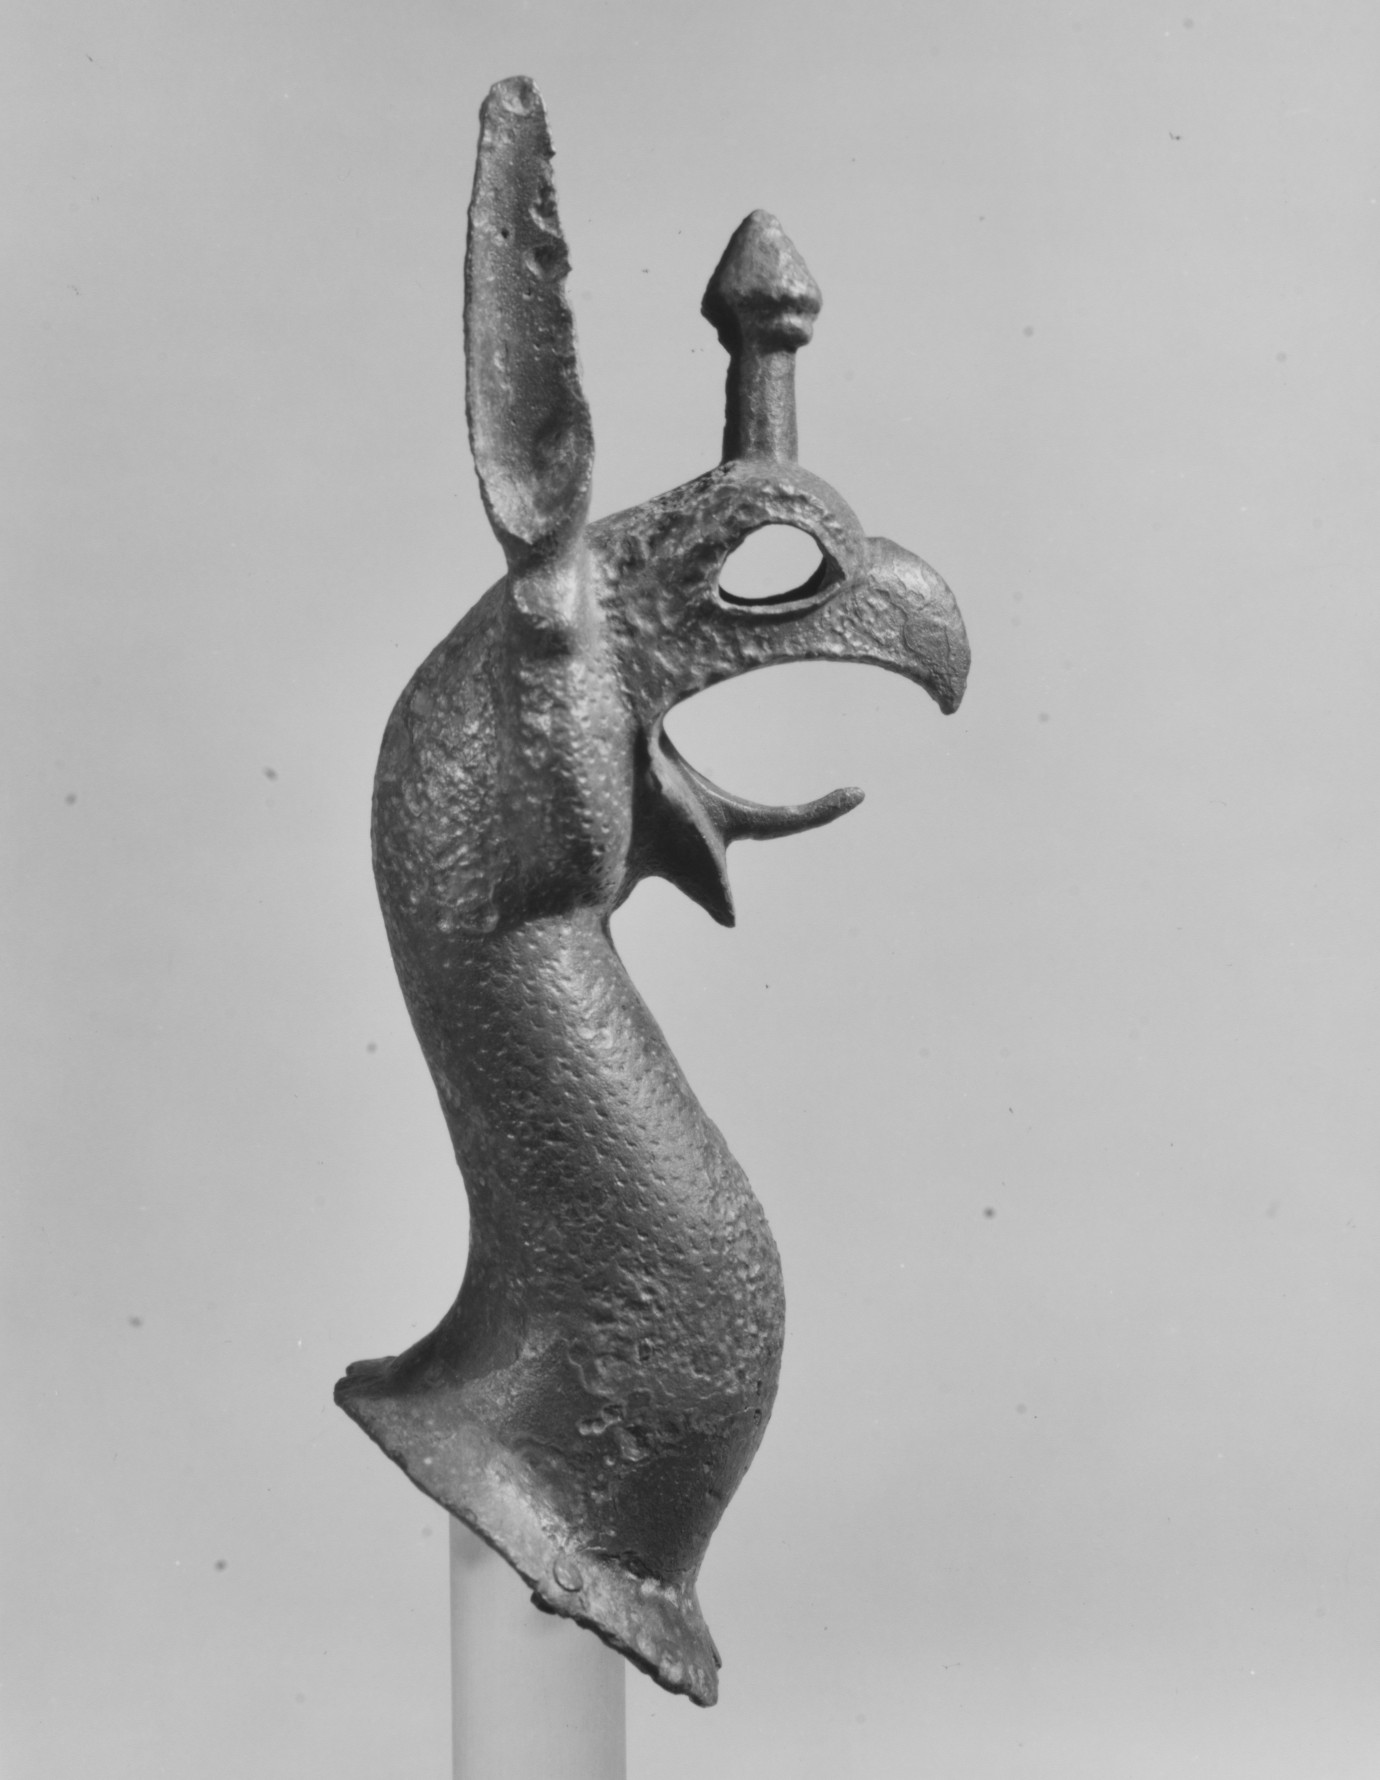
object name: head of a griffin from a cauldron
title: Bronze griffin attachment from a cauldron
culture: greek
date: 667-635 BCE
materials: bronze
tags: griffins